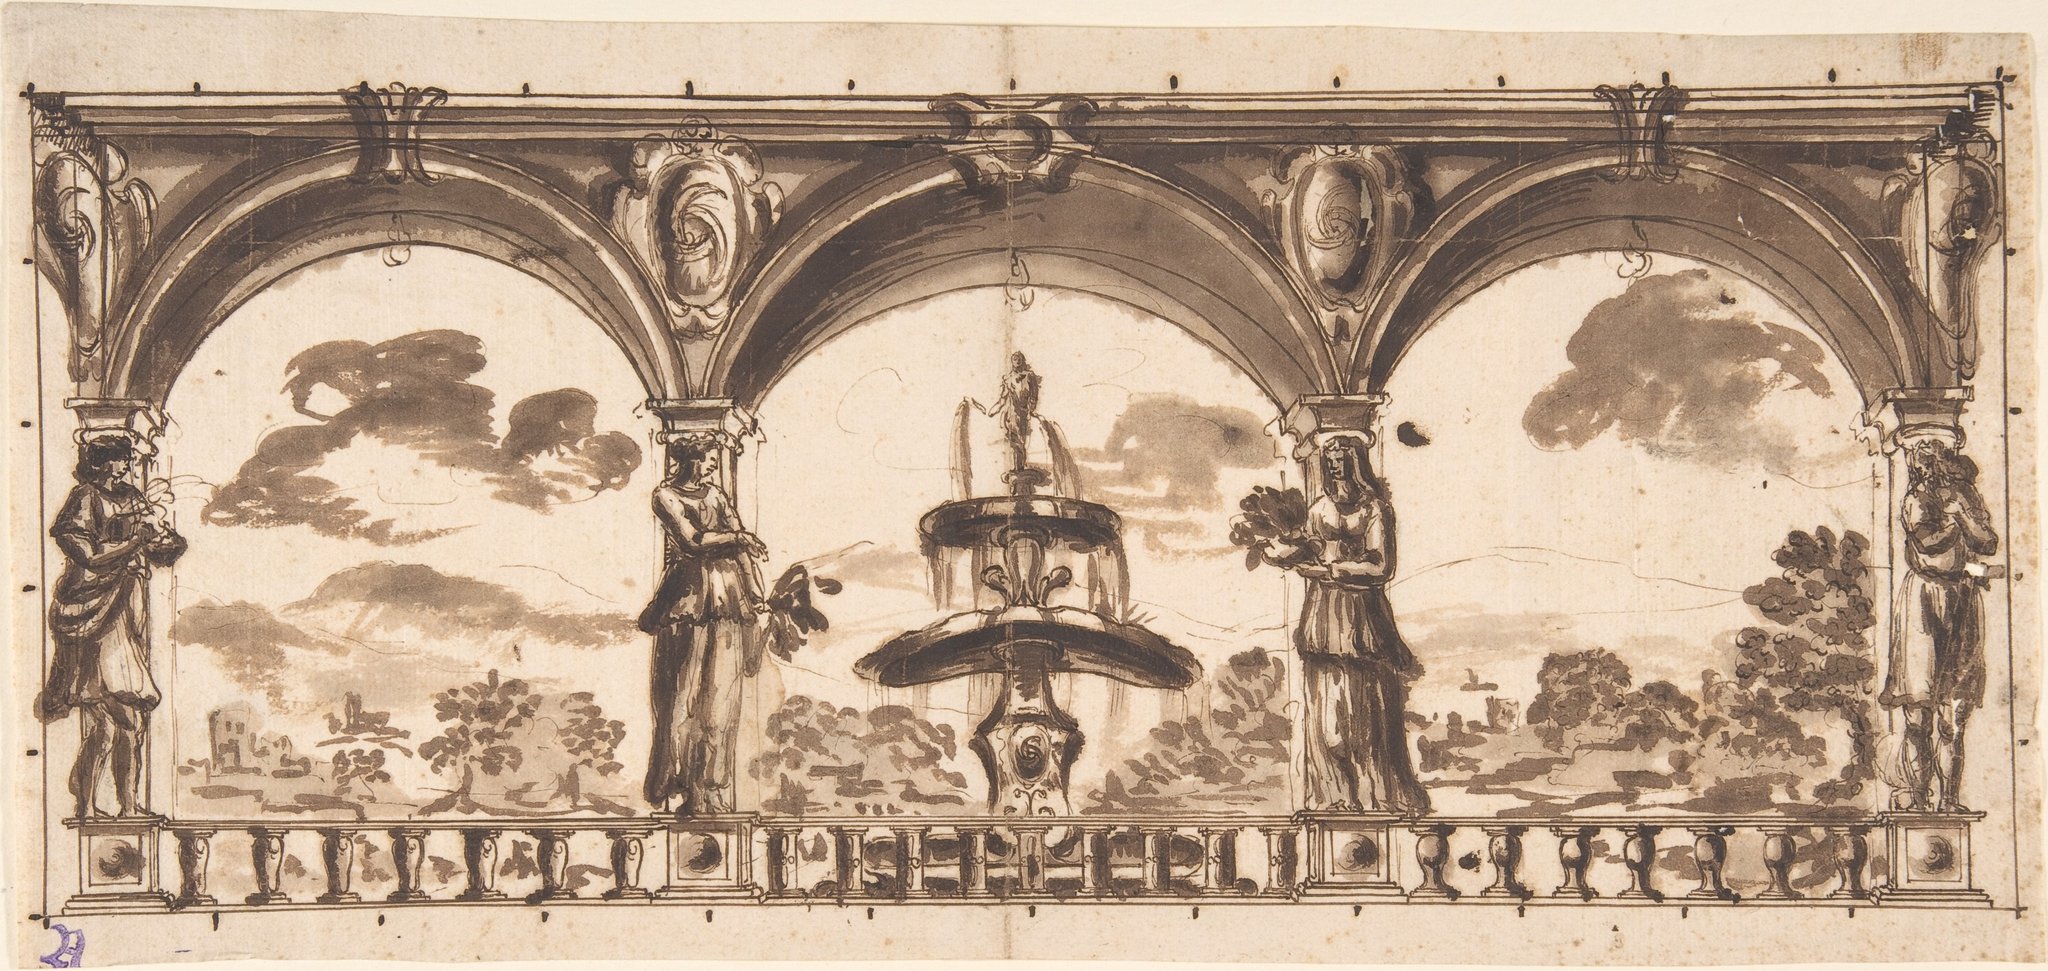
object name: drawing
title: Loggia with Caryatids before a Fountain and Landscape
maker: anonymous, italian, roman-bolognese, 17th century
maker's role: artist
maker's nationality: italian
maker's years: 1600-1700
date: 1601-1700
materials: chalk, ink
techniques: brush, pen, wash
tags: fountains,caryatids,landscapes